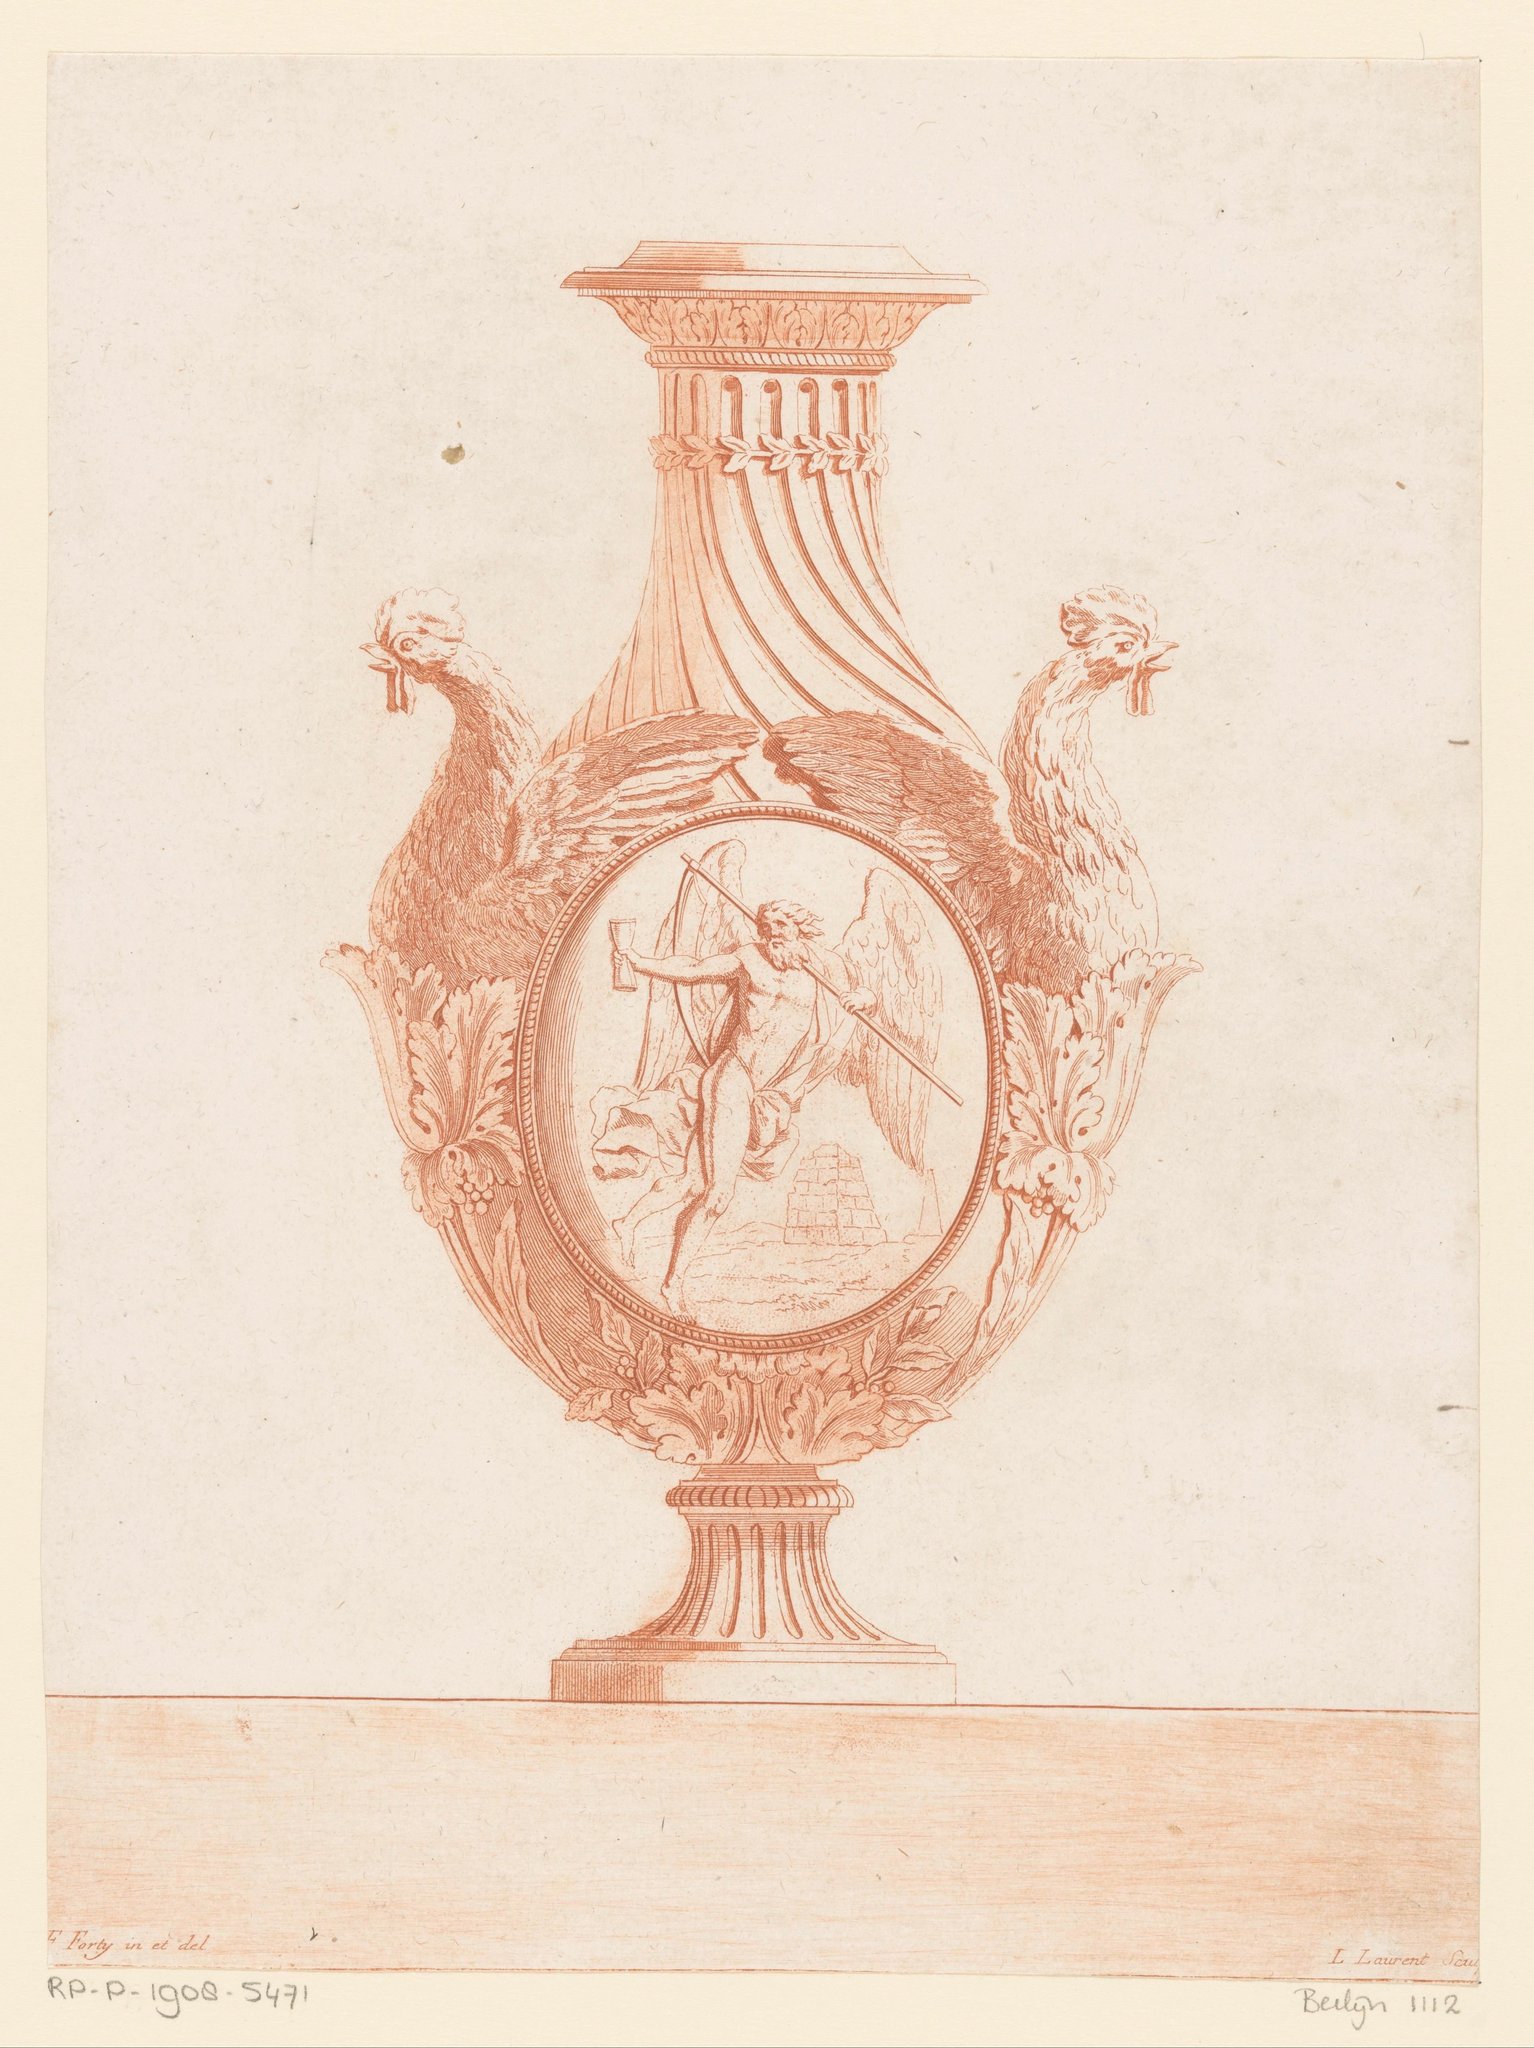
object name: ornament print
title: IIeme [IIIeme] Cahier de Vases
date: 1775-1785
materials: paper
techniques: engraving, etching, intaglio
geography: paris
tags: vase ~ ornament, fowl (cock, hen, chicken, etc.), father time, man with wings and scythe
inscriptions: collector's mark: Lugt 2228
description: Een geornamenteerde vaas met kippen aan weerszijden van een medaillon met een gevleugelde Vader Tijd met zeis en zandloper.